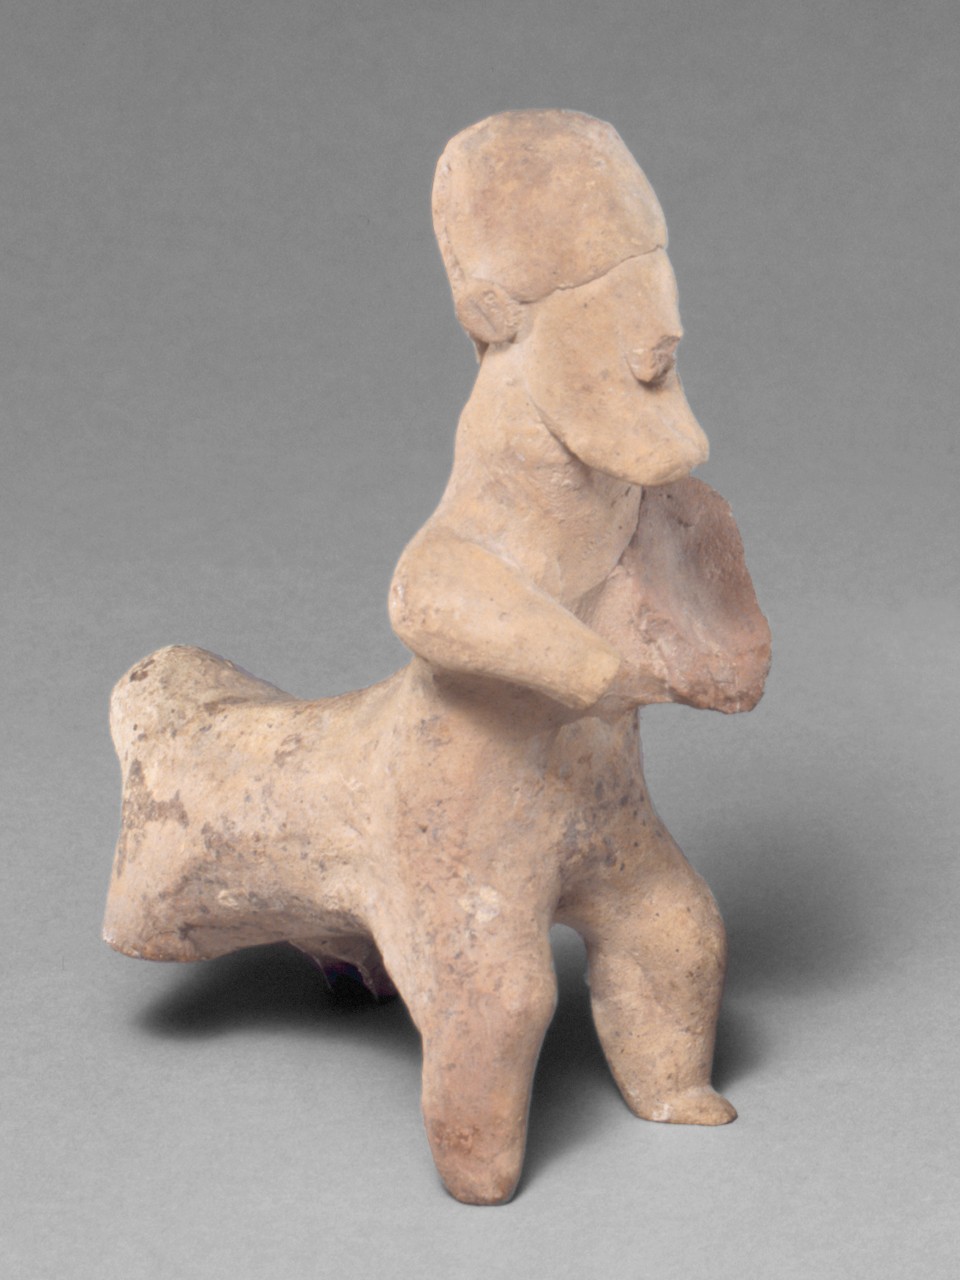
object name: figurine of a centaur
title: Centaur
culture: cypriot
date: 600-480 BCE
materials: terracotta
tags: centaurs